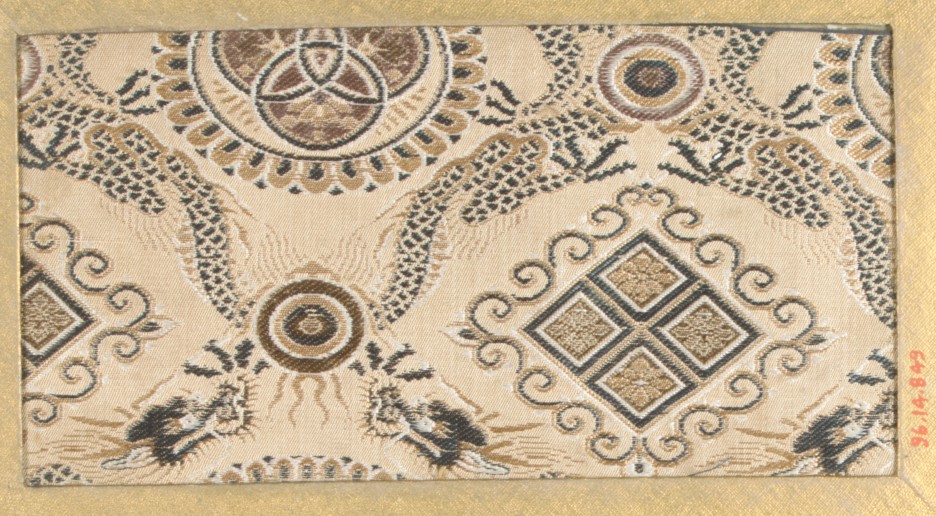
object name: piece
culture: japanese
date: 1701-1900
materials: silk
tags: dragons